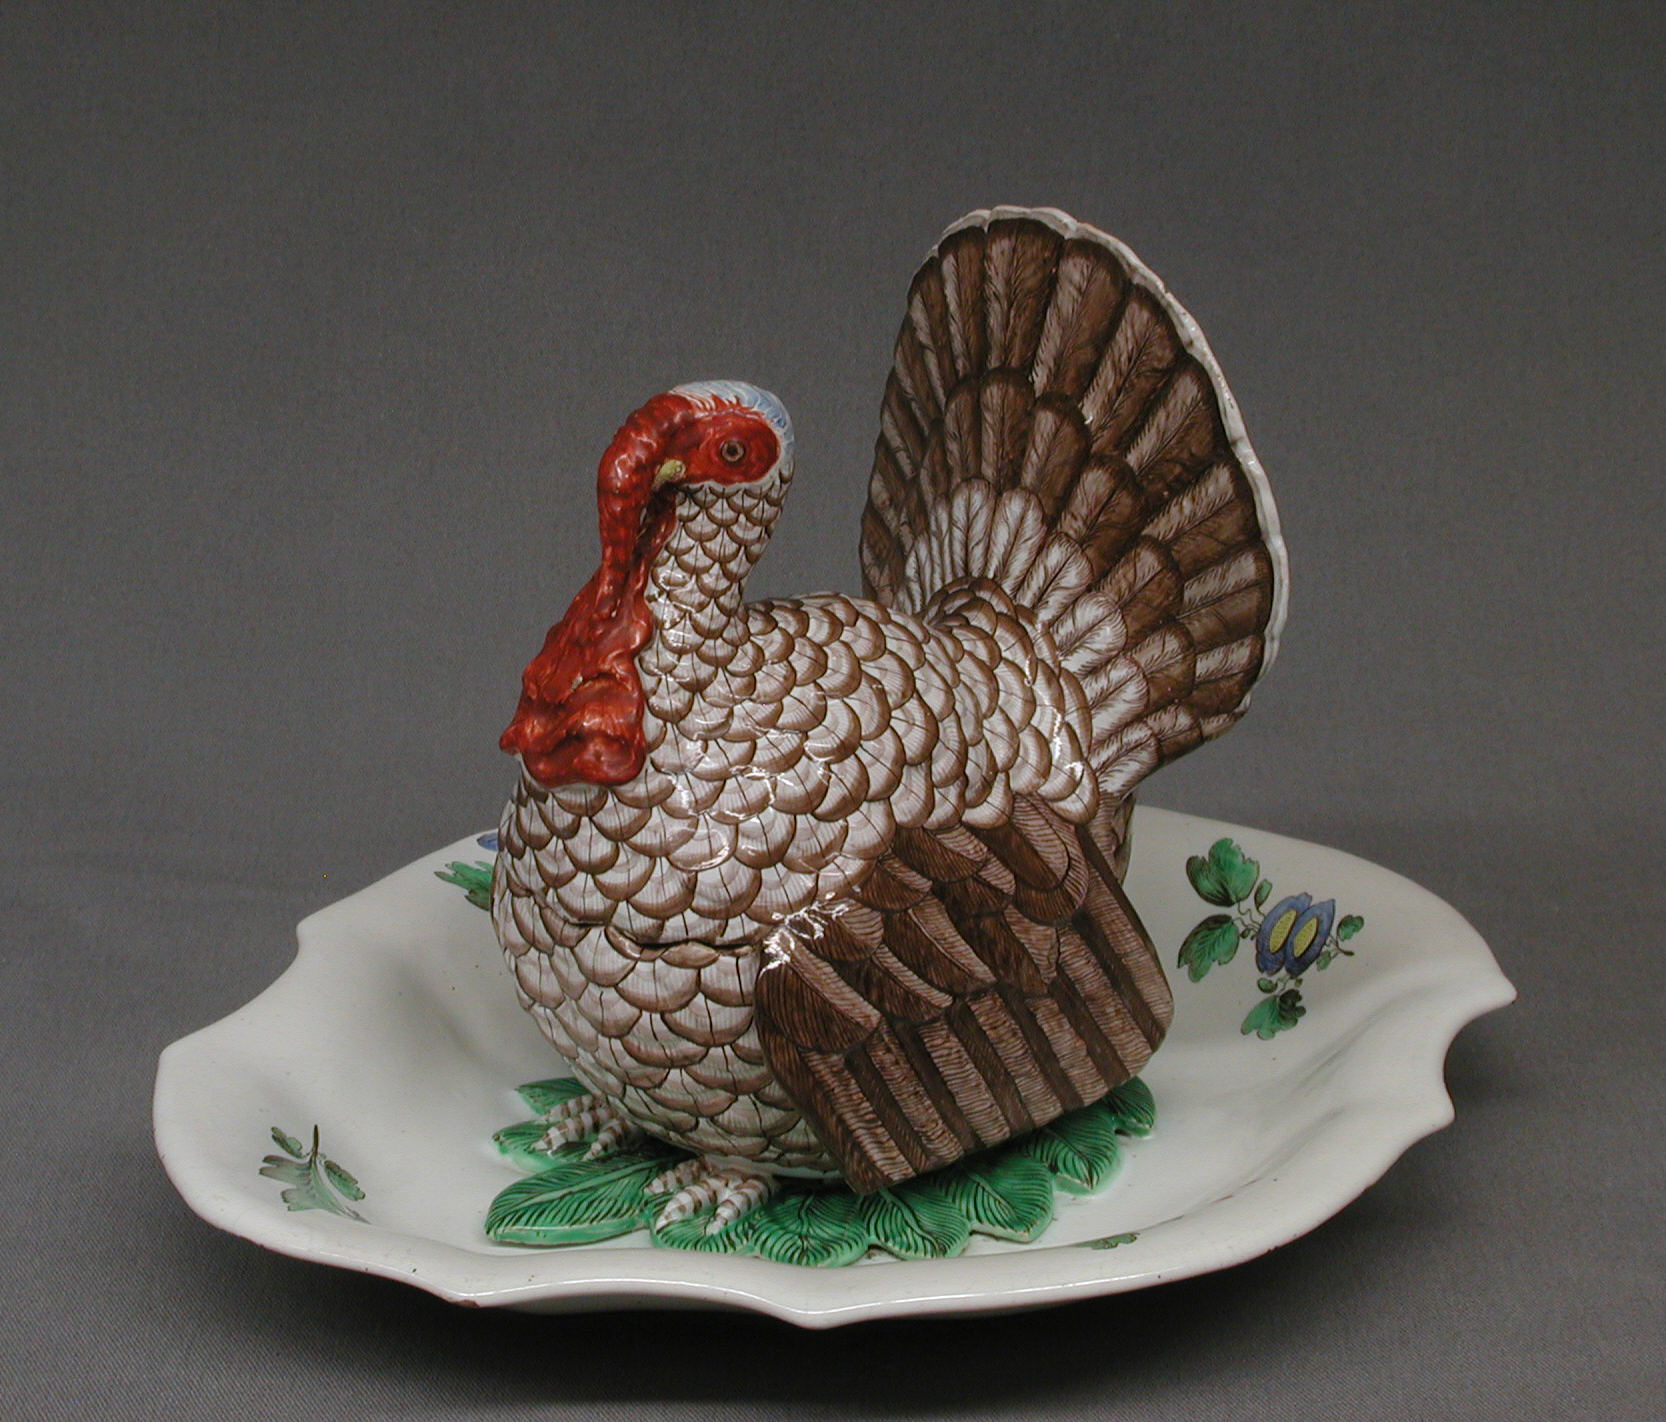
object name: tureen with cover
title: Tureen with cover in the form of a turkey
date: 1760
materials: earthenware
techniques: glazing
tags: turkeys